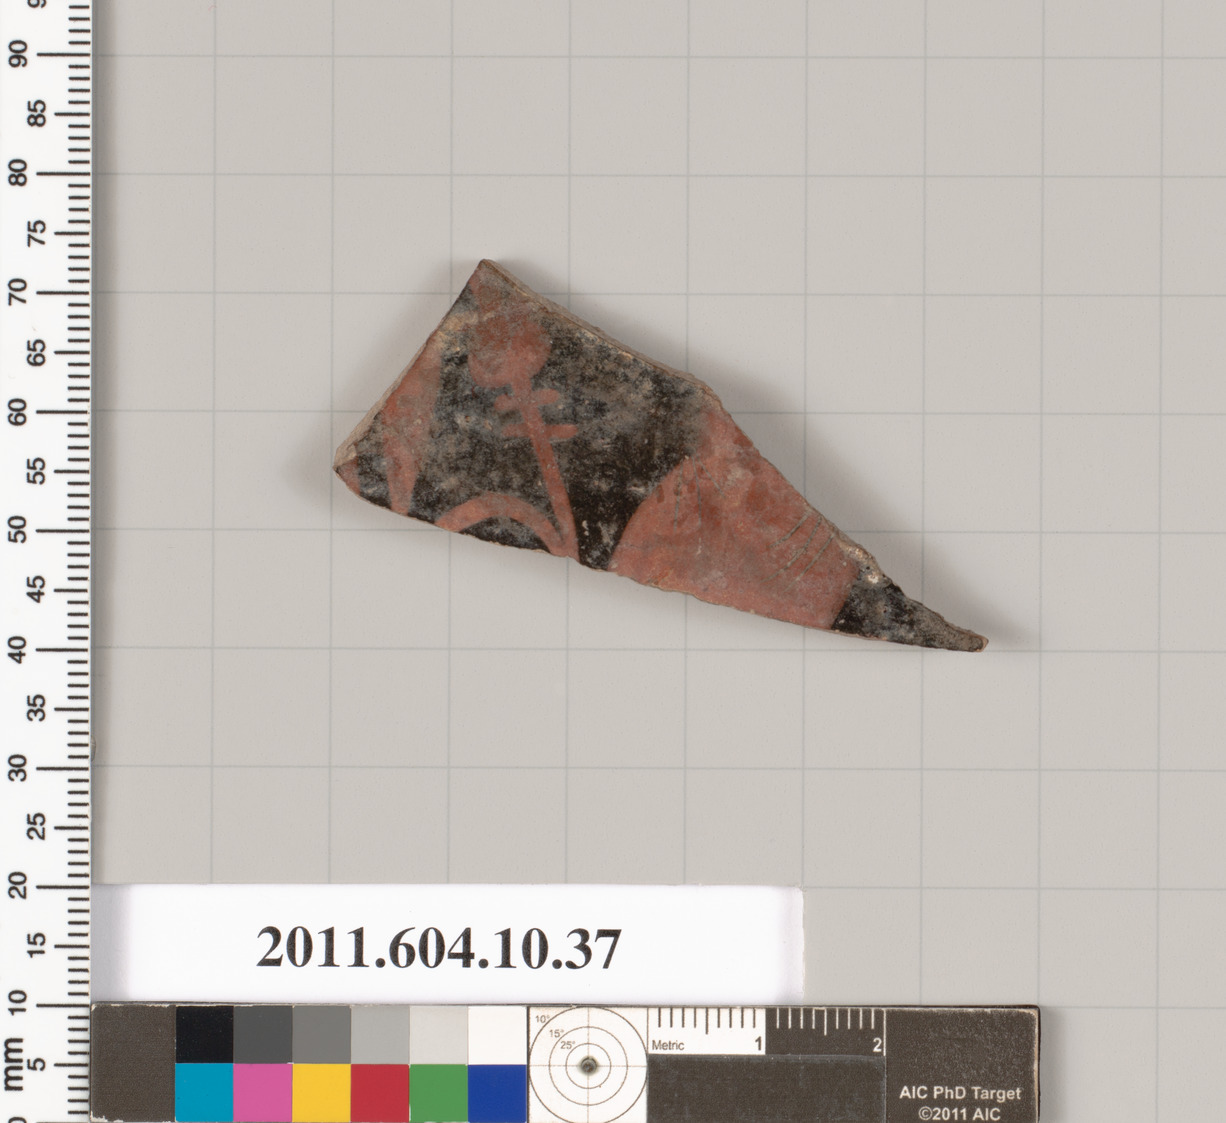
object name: kylix fragment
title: Terracotta fragment of a kylix (drinking cup)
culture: etruscan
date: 434-368 BCE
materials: terracotta